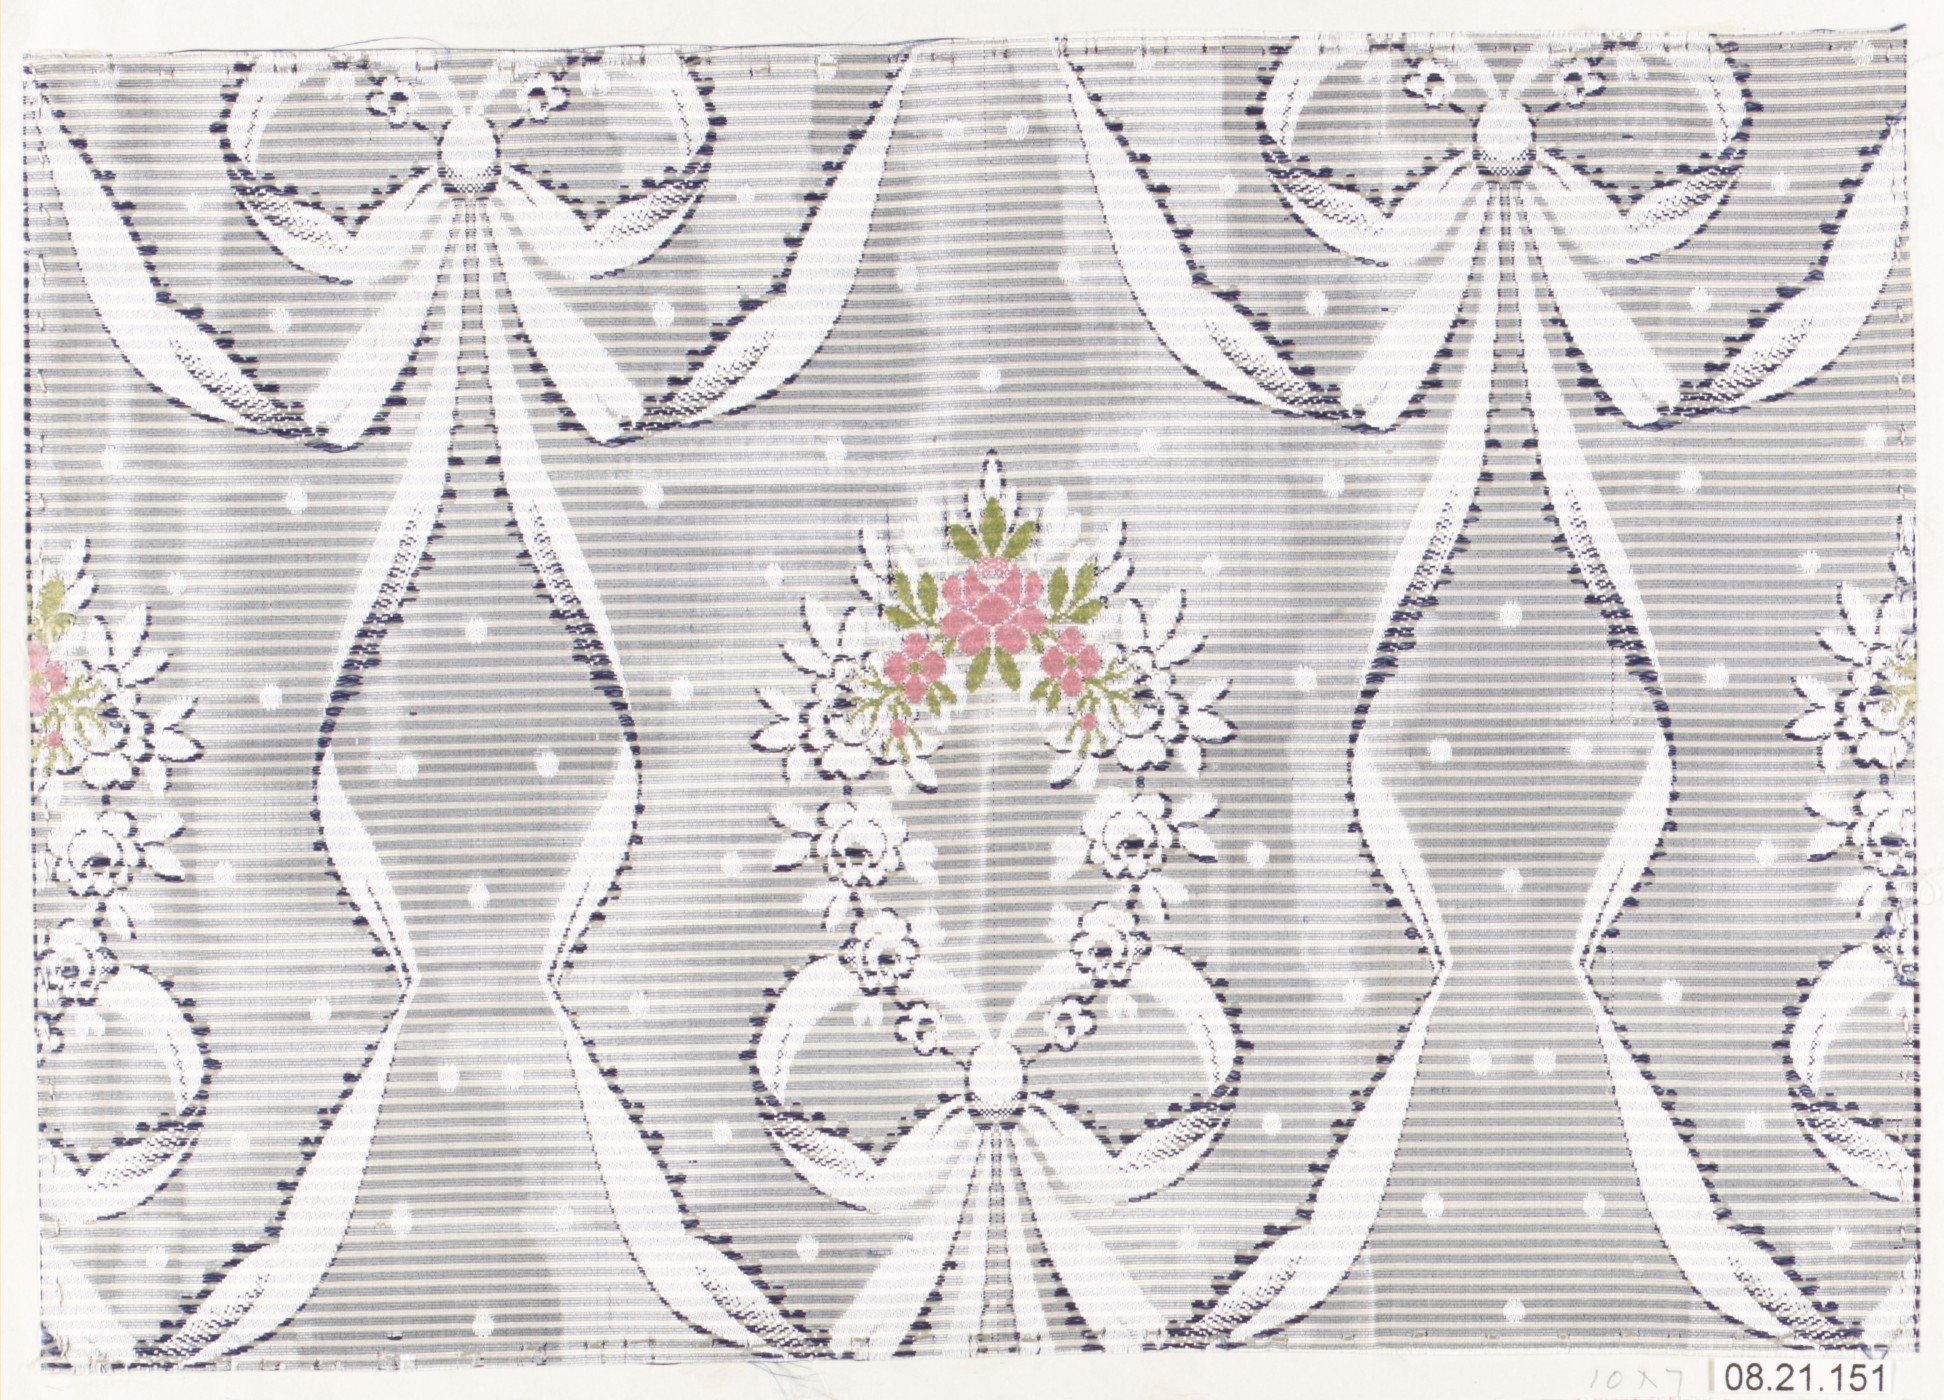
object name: textile sample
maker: Anonymous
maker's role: designer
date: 1900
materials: silk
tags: flowers